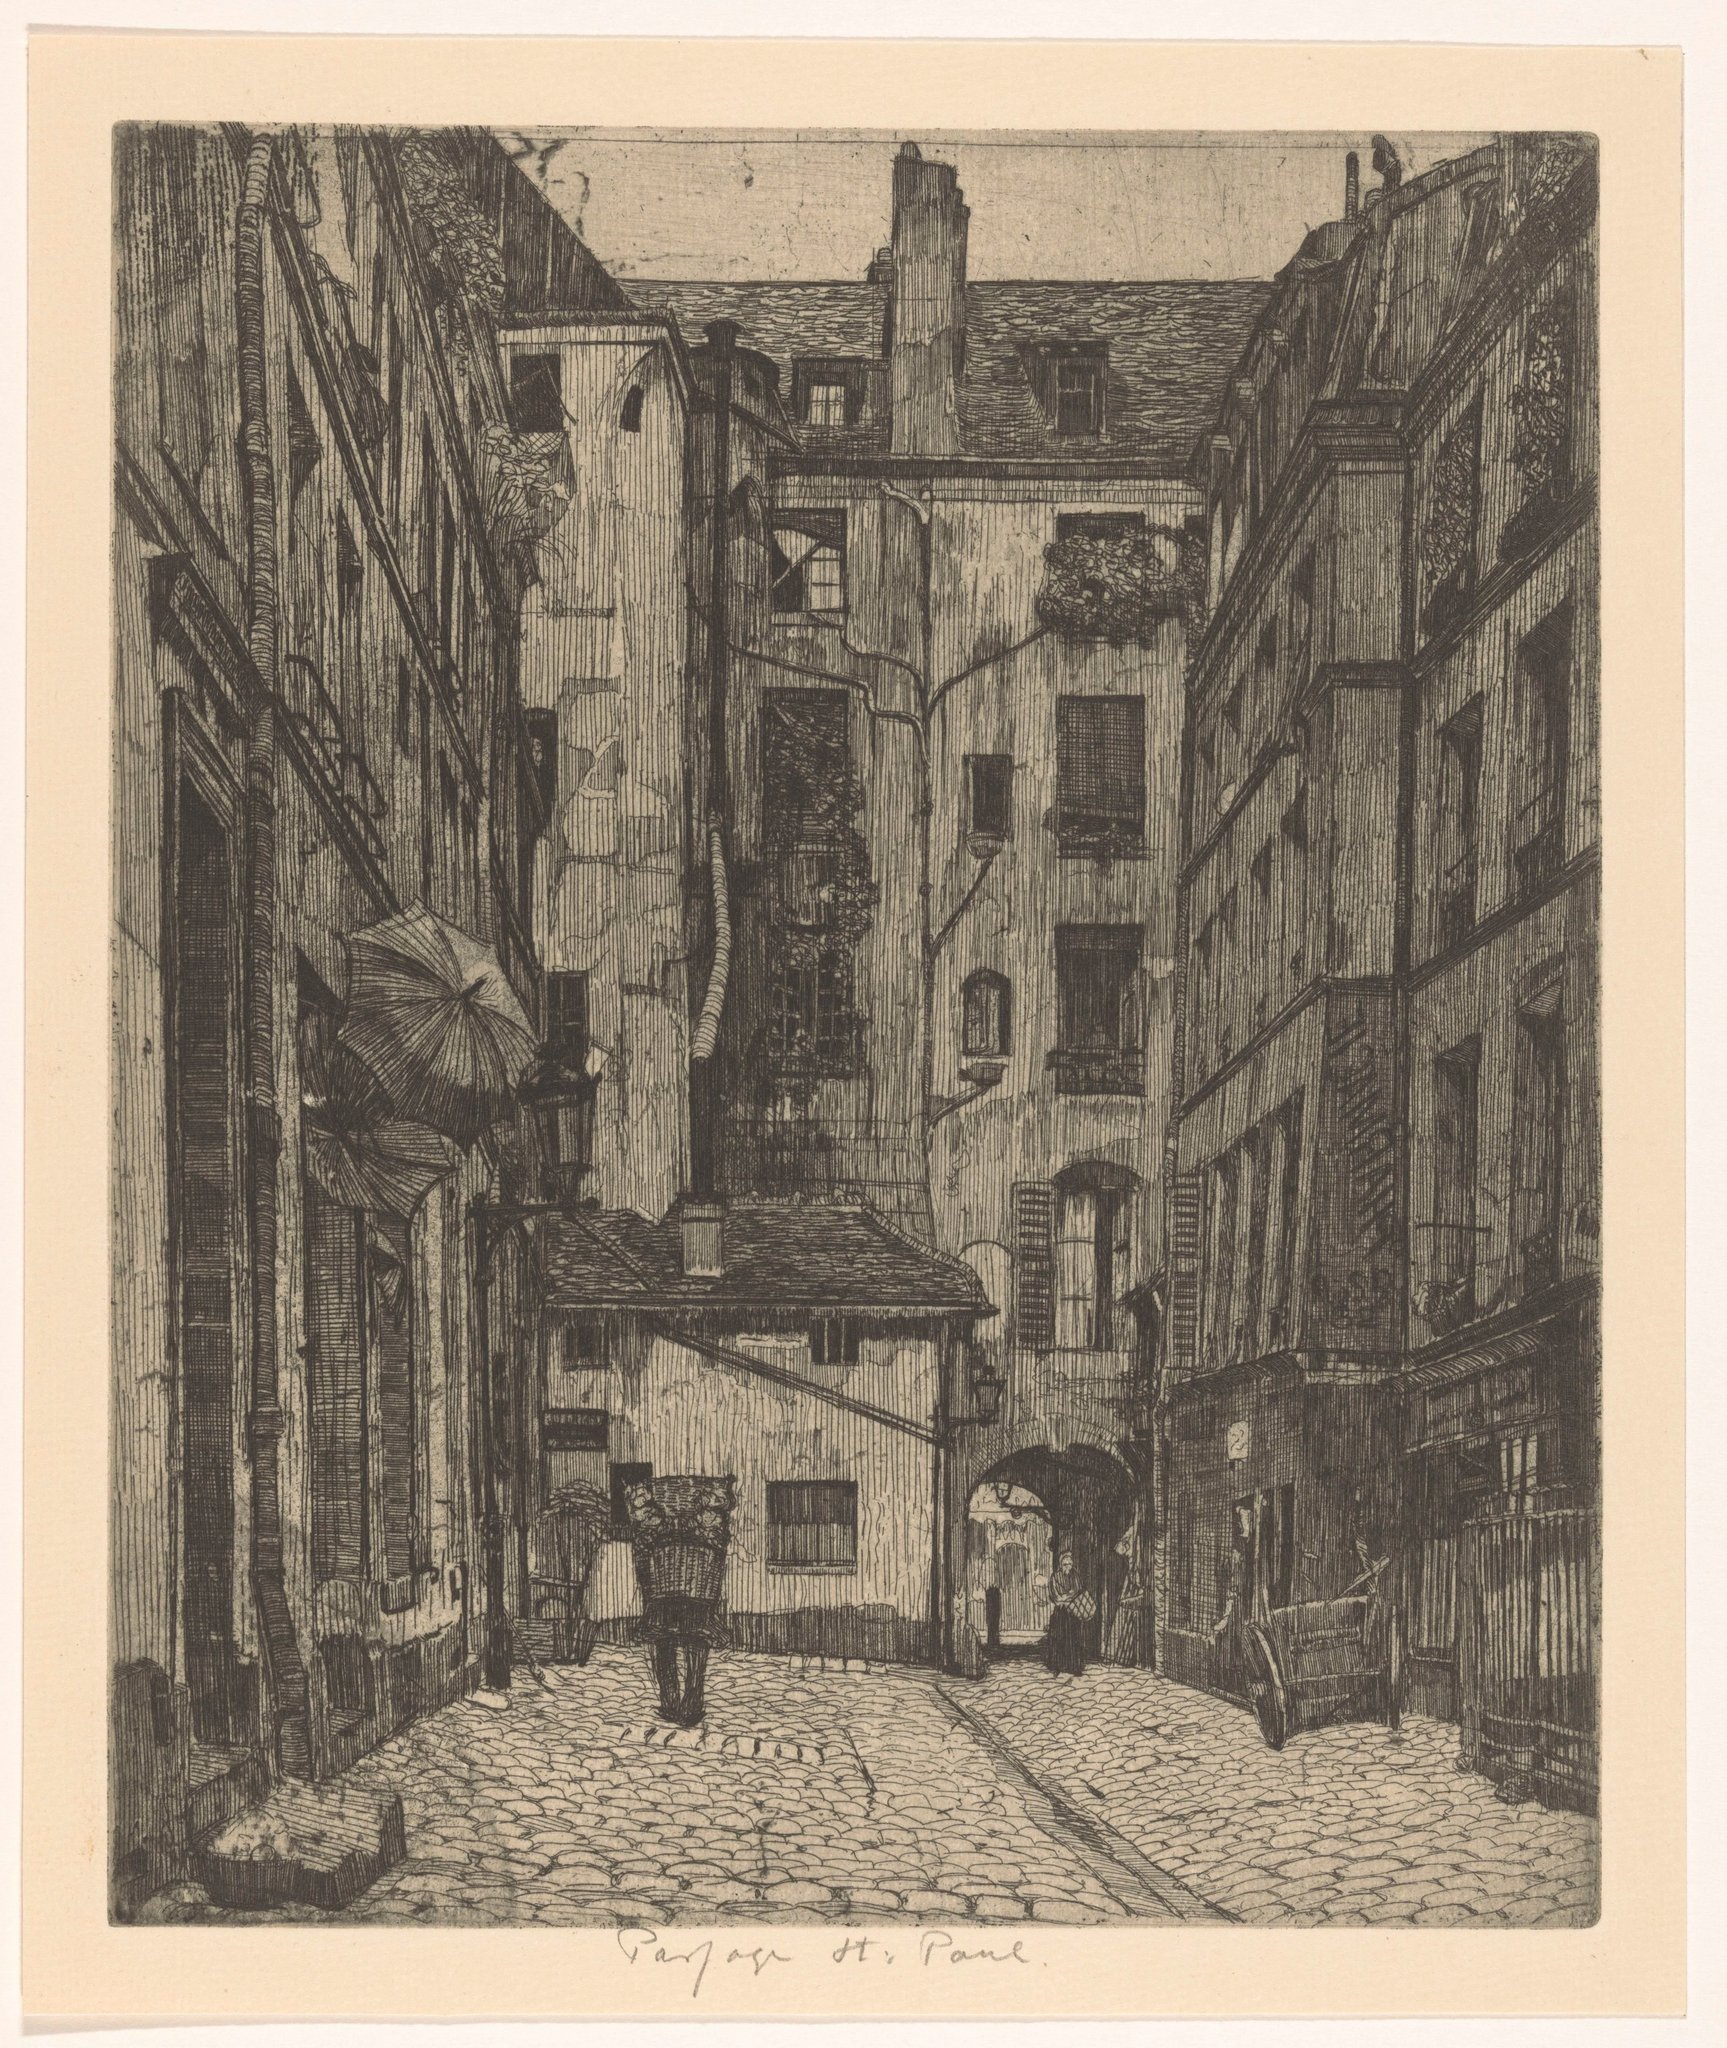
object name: print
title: Passage Saint-Paul in Parijs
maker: martin monnickendam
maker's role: draughtsman, painter, print maker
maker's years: 1874-1943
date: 1896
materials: paper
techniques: etching, intaglio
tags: passage, paris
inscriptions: collector's mark: Lugt 2228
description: Gezicht op een binnenplaats. Links hangen twee paraplu's aan een gevel.